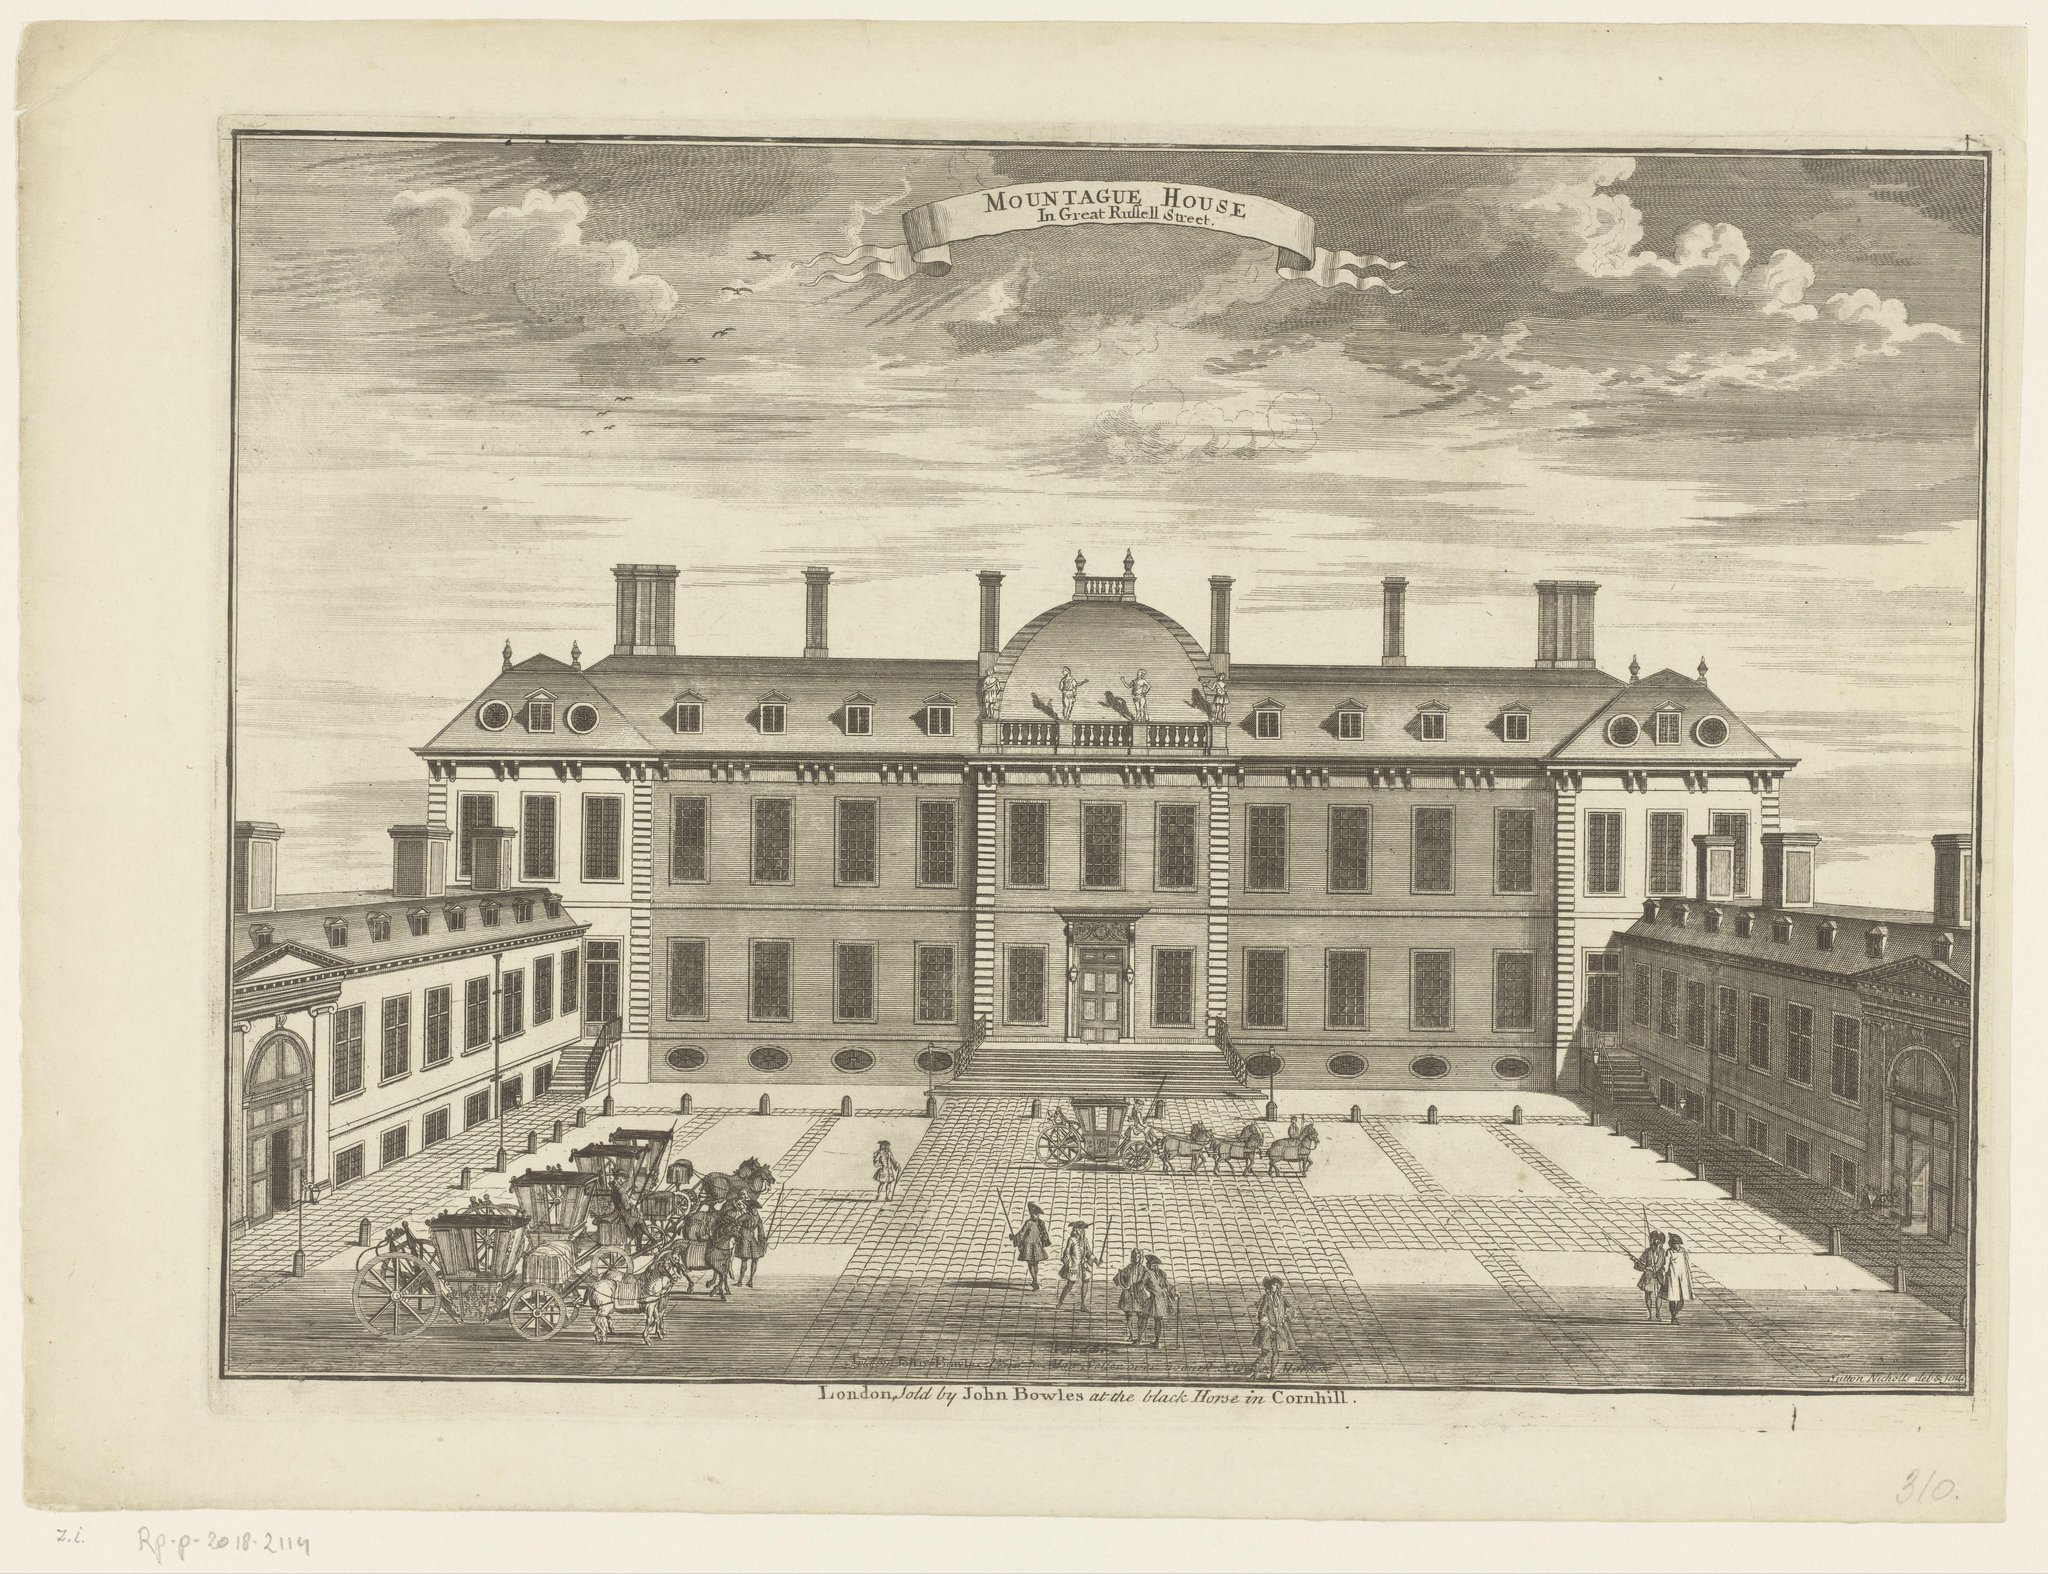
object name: print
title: Gezicht op Montagu House, te Londen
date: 1733-1766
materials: paper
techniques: etching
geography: london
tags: façade (of house or building), london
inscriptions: collector's mark: Lugt 2228